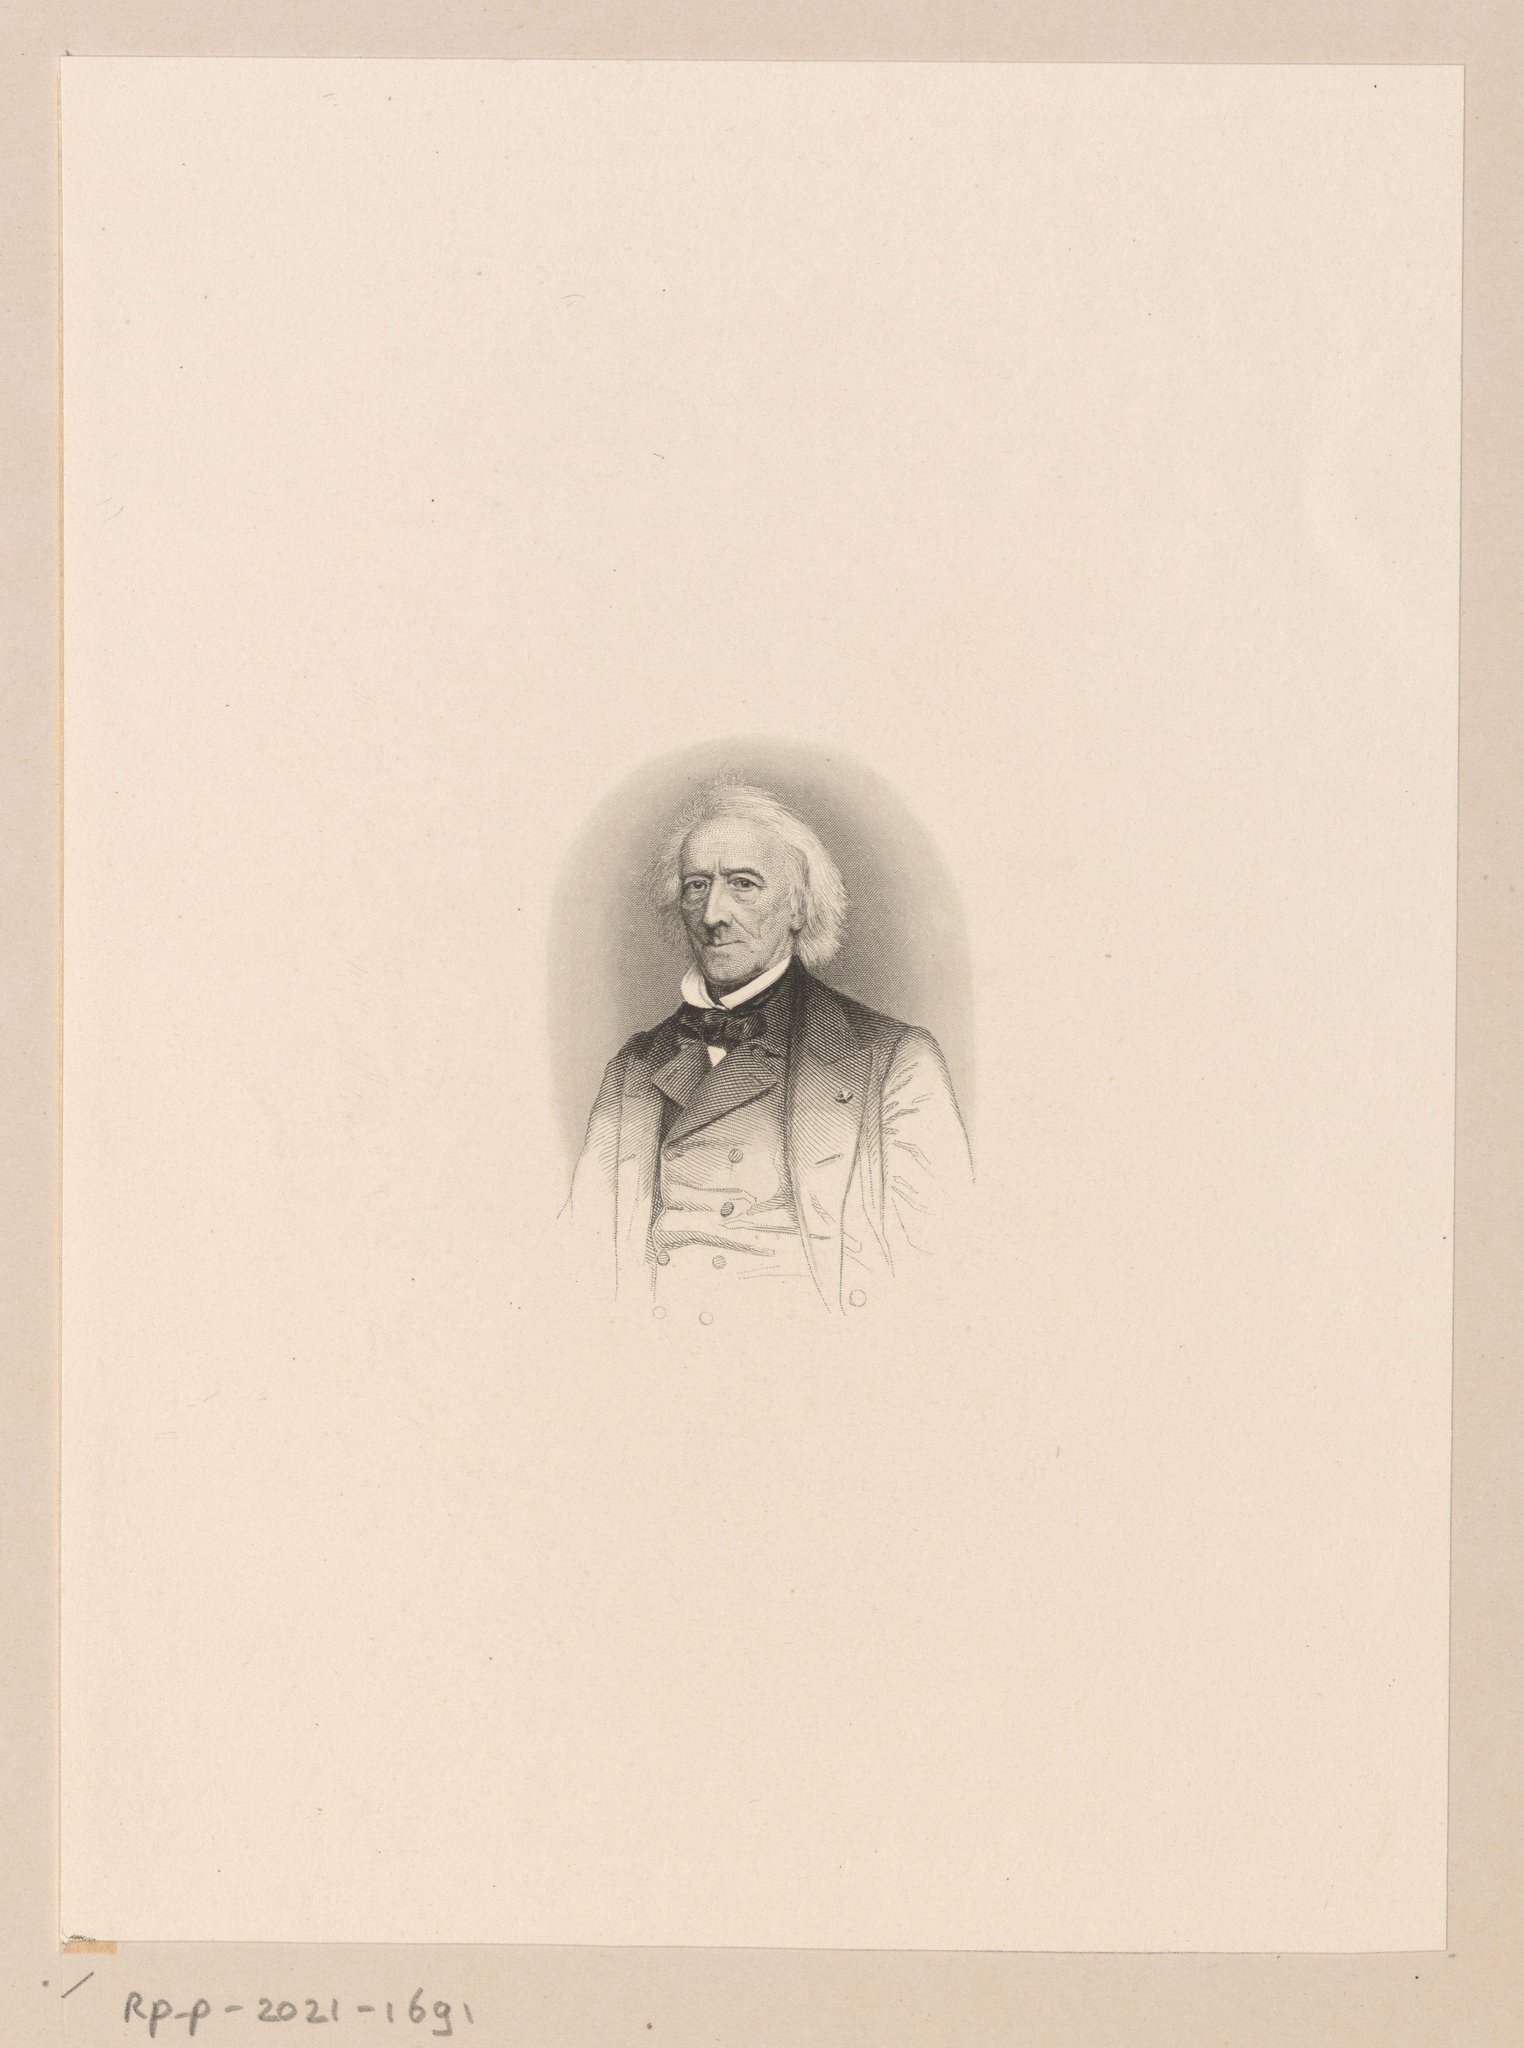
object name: print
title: Portret van Jacob van Lennep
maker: Anonymous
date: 1860-1899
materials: paper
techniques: etching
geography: netherlands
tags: amsterdam, jacob van lennep, historical persons, portrait of a writer